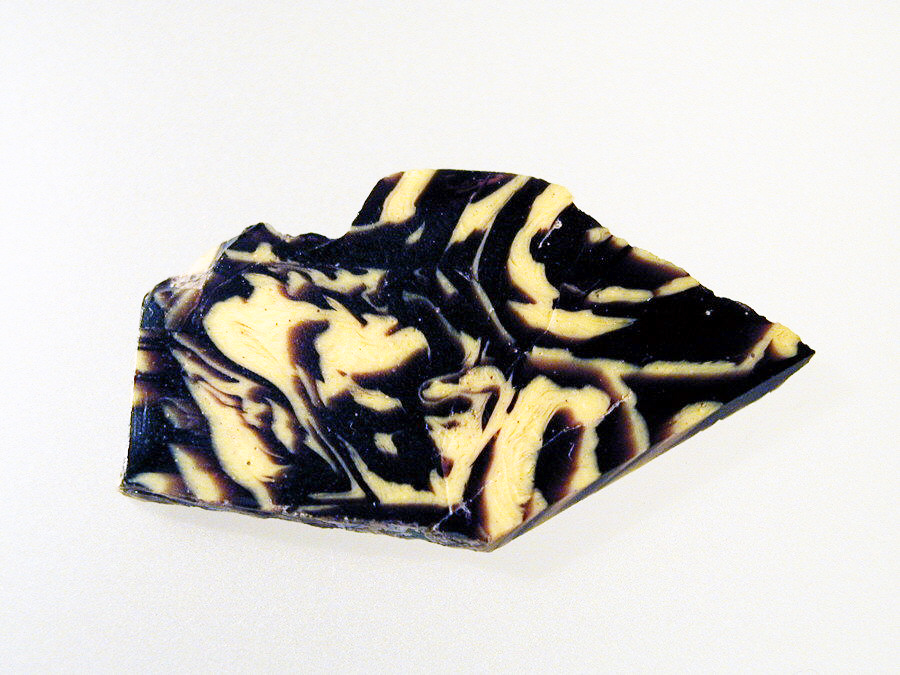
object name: fragment, mosaic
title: Glass mosaic inlay fragment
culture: roman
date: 34 BCE-33 CE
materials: glass